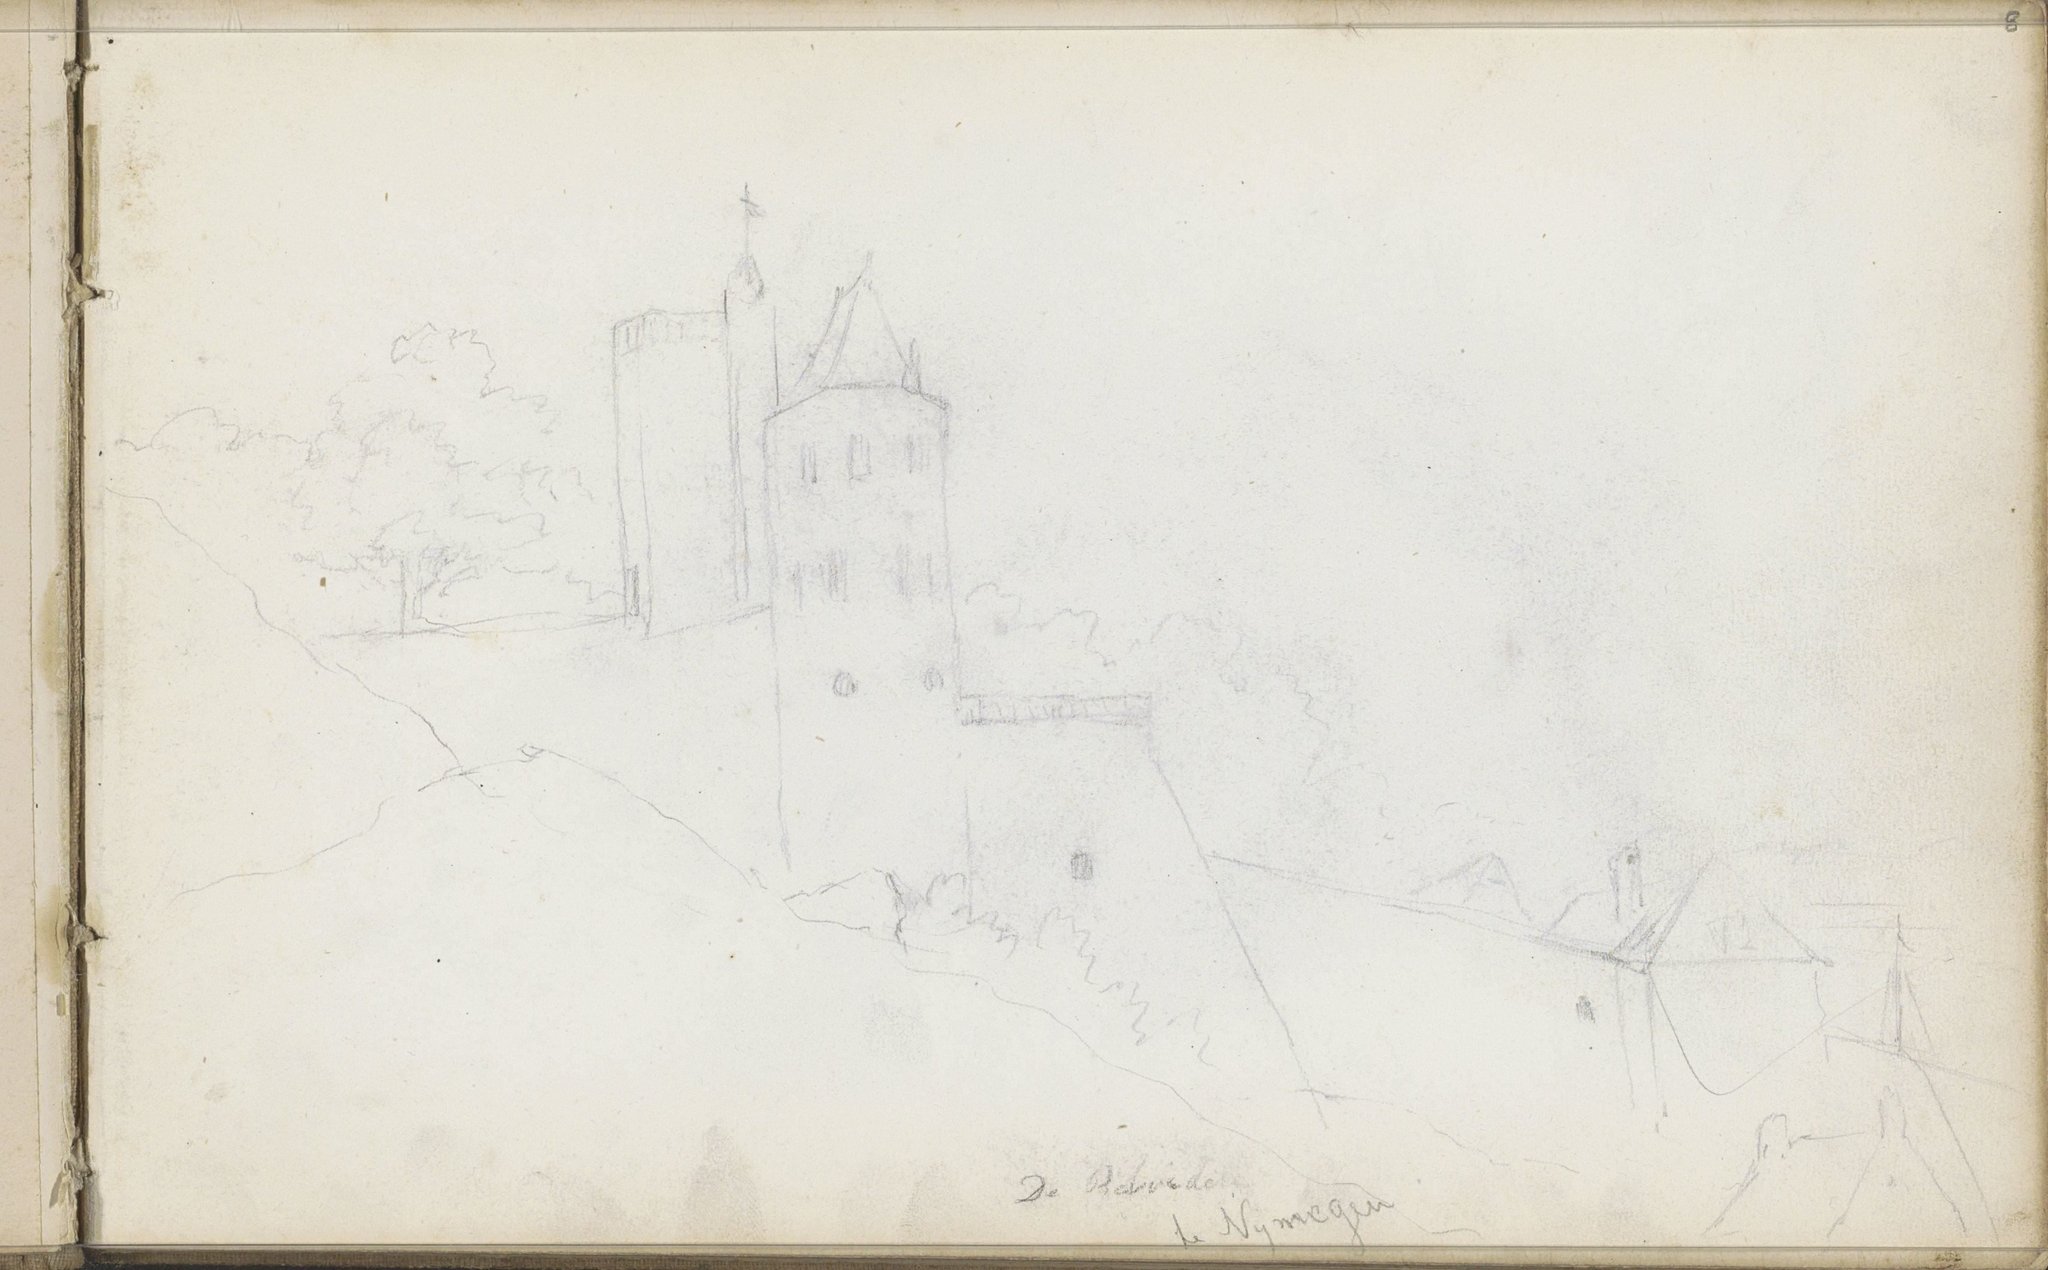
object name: sketchbook leaf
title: Belvédère te Nijmegen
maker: willem cornelis rip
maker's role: draughtsman, painter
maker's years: 1856-1922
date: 1874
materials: paper, pencil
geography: nijmegen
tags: tower (of house or building)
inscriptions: annotation: ‘De Belvédere/ te Nijmegen’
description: Blad 8 recto uit een schetsboek met 47 bladen.